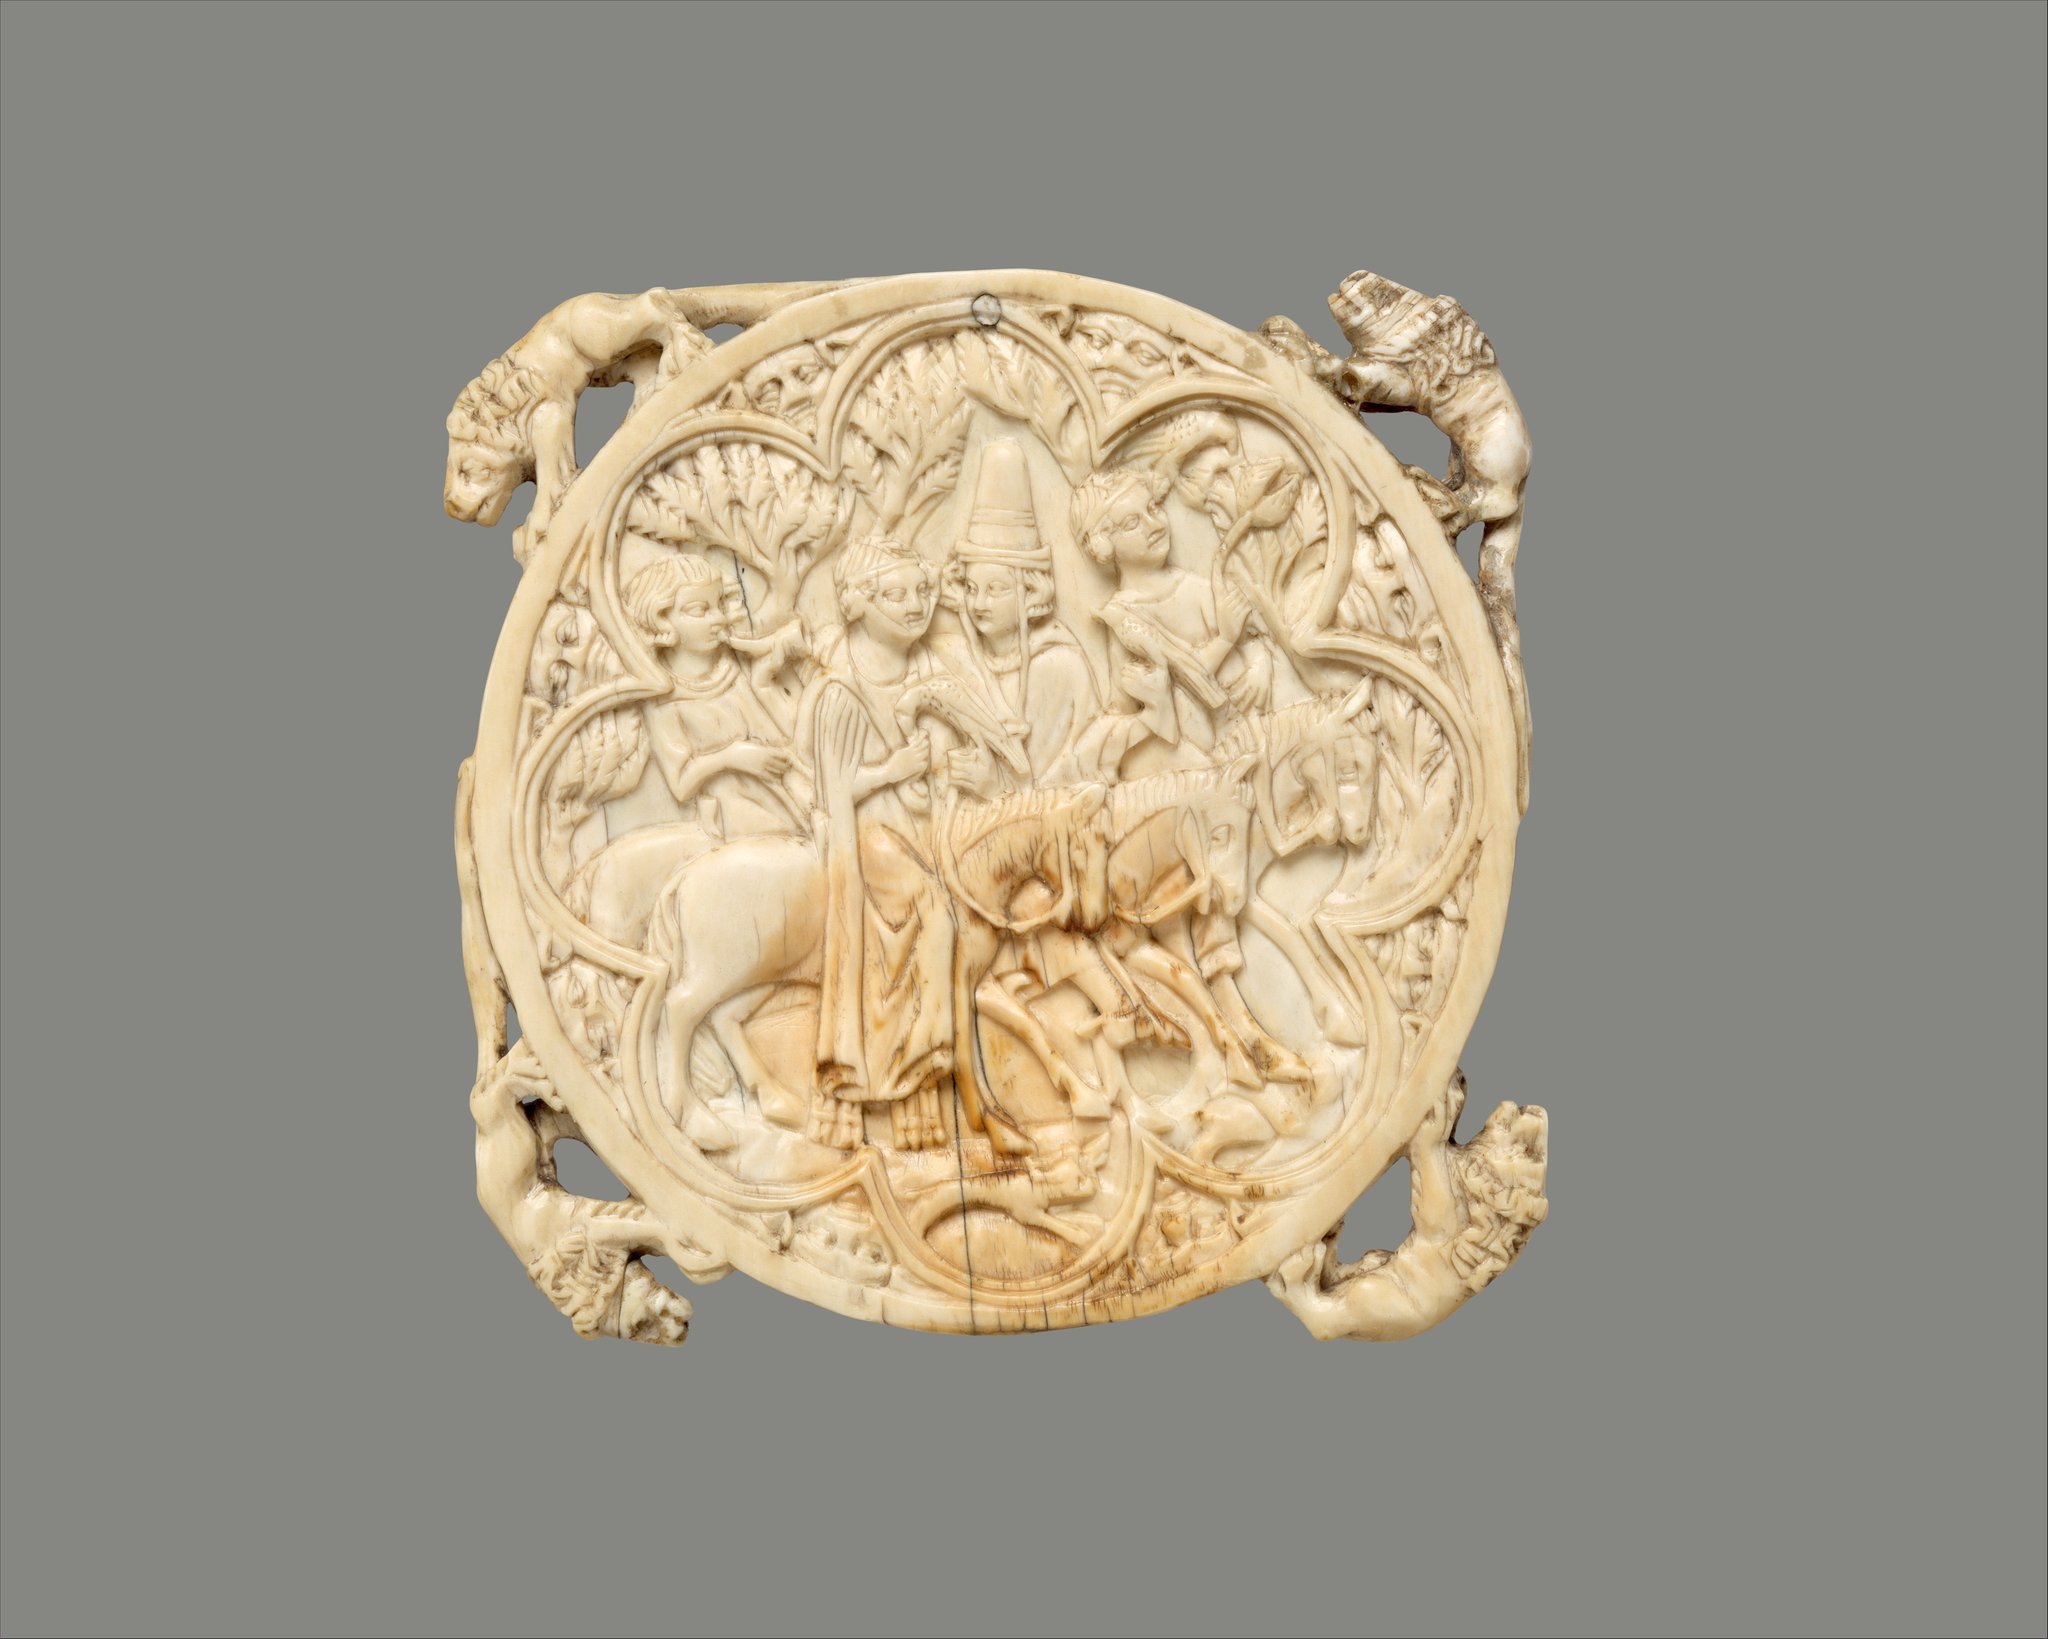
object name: mirror case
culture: french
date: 1350-1375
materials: ivory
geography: france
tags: falcons,men,women,horses,lions